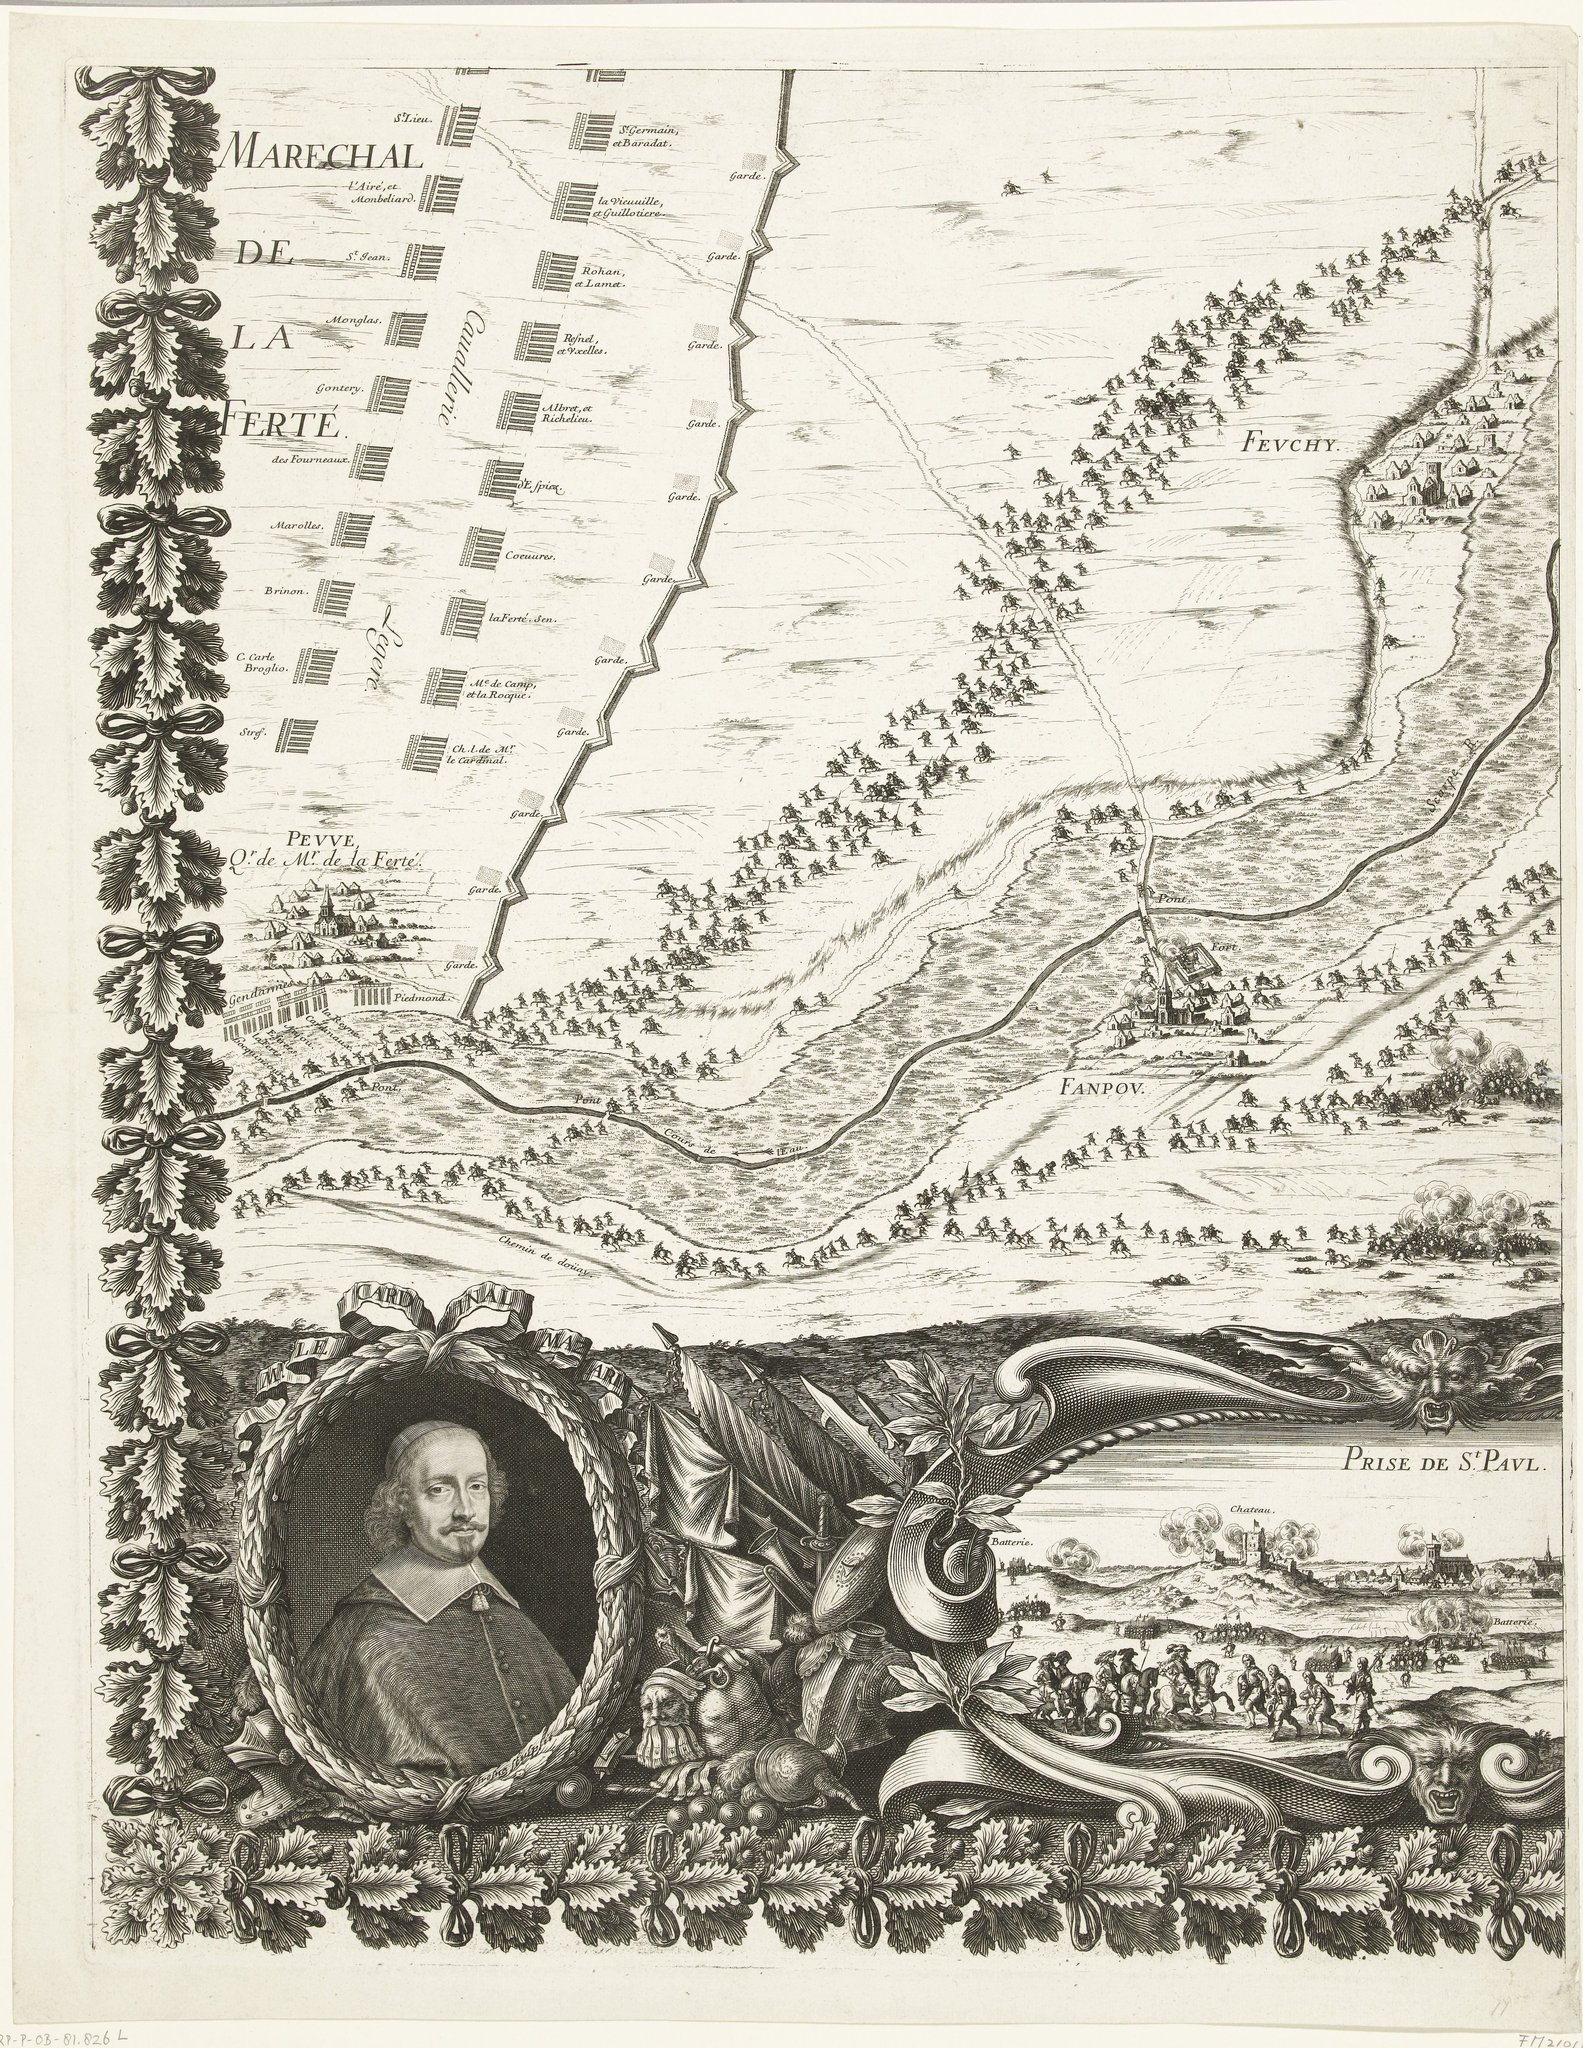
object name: print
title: Le siege d'Arras leve par la defaite des ennemis 1654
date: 1655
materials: paper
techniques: engraving, etching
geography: france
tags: vienna, leopold willem van oostenrijk (landvoogd der zuidelijke nederlanden), raising the siege with outside assistance, relief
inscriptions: date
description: Ontzet van de stad Arras (Atrecht), belegerd door de Spanjaarden, 23-25 augustus 1654. Arras ontzet door het Franse leger onder de maarschalk Turenne van het beleg door de Spanjaarden onder Louis de Condé en aartshertog Leopold Willem. Eerste blad in de onderste rij. Deel van de kaart van het beleg met vluchtende troepen, onderaan een portret van kardinaal Marzarin en een deel van de cartouche met de inname van St. Paul. Onderdeel van een ongemonteerd geheel bestaande uit een titelblad en een grote voorstelling op vijftien platen (de halve plaat rechtsonder ontbreekt).